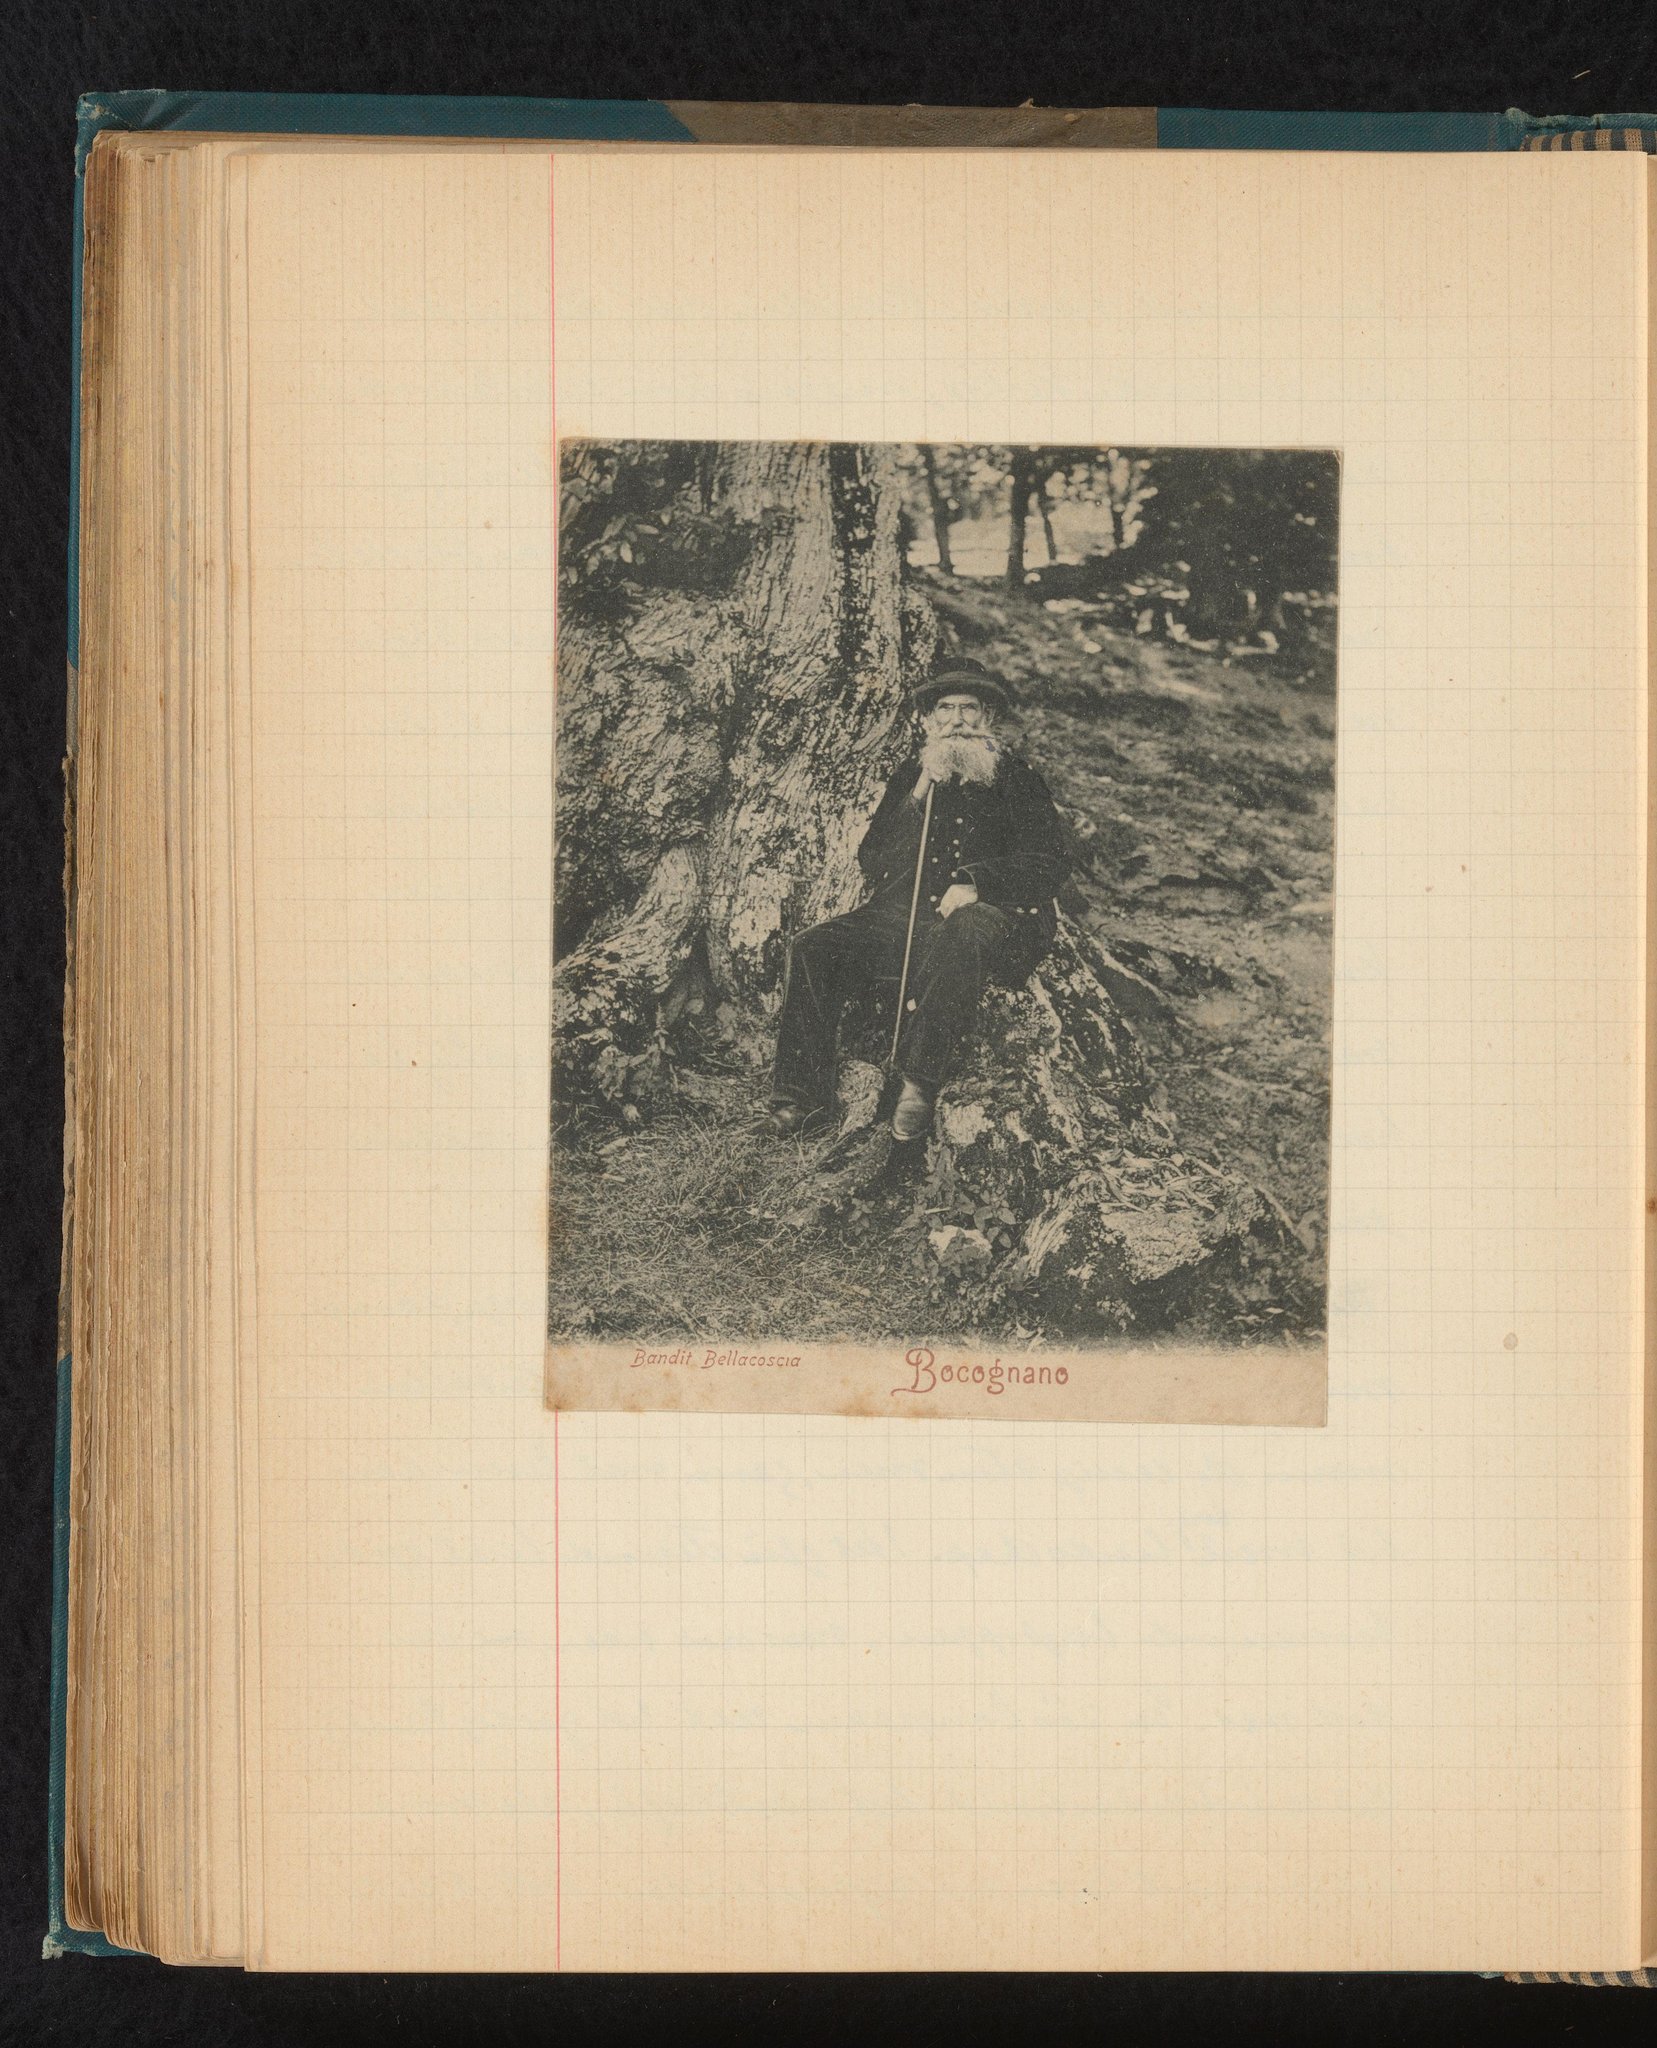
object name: ansichtkaart, prentbriefkaart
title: Bandiet Bellacoscia, Bocognano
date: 1902-1904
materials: cardboard, paper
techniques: photograph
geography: corsica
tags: trees, walking-stick, staff, historical persons, sitting with arms or elbows on the knees, criminals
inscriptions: inscription: ‘Bandit Bellascoscia/ Bocognano’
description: Deze fotomechanische afdruk maakt deel uit van een album.